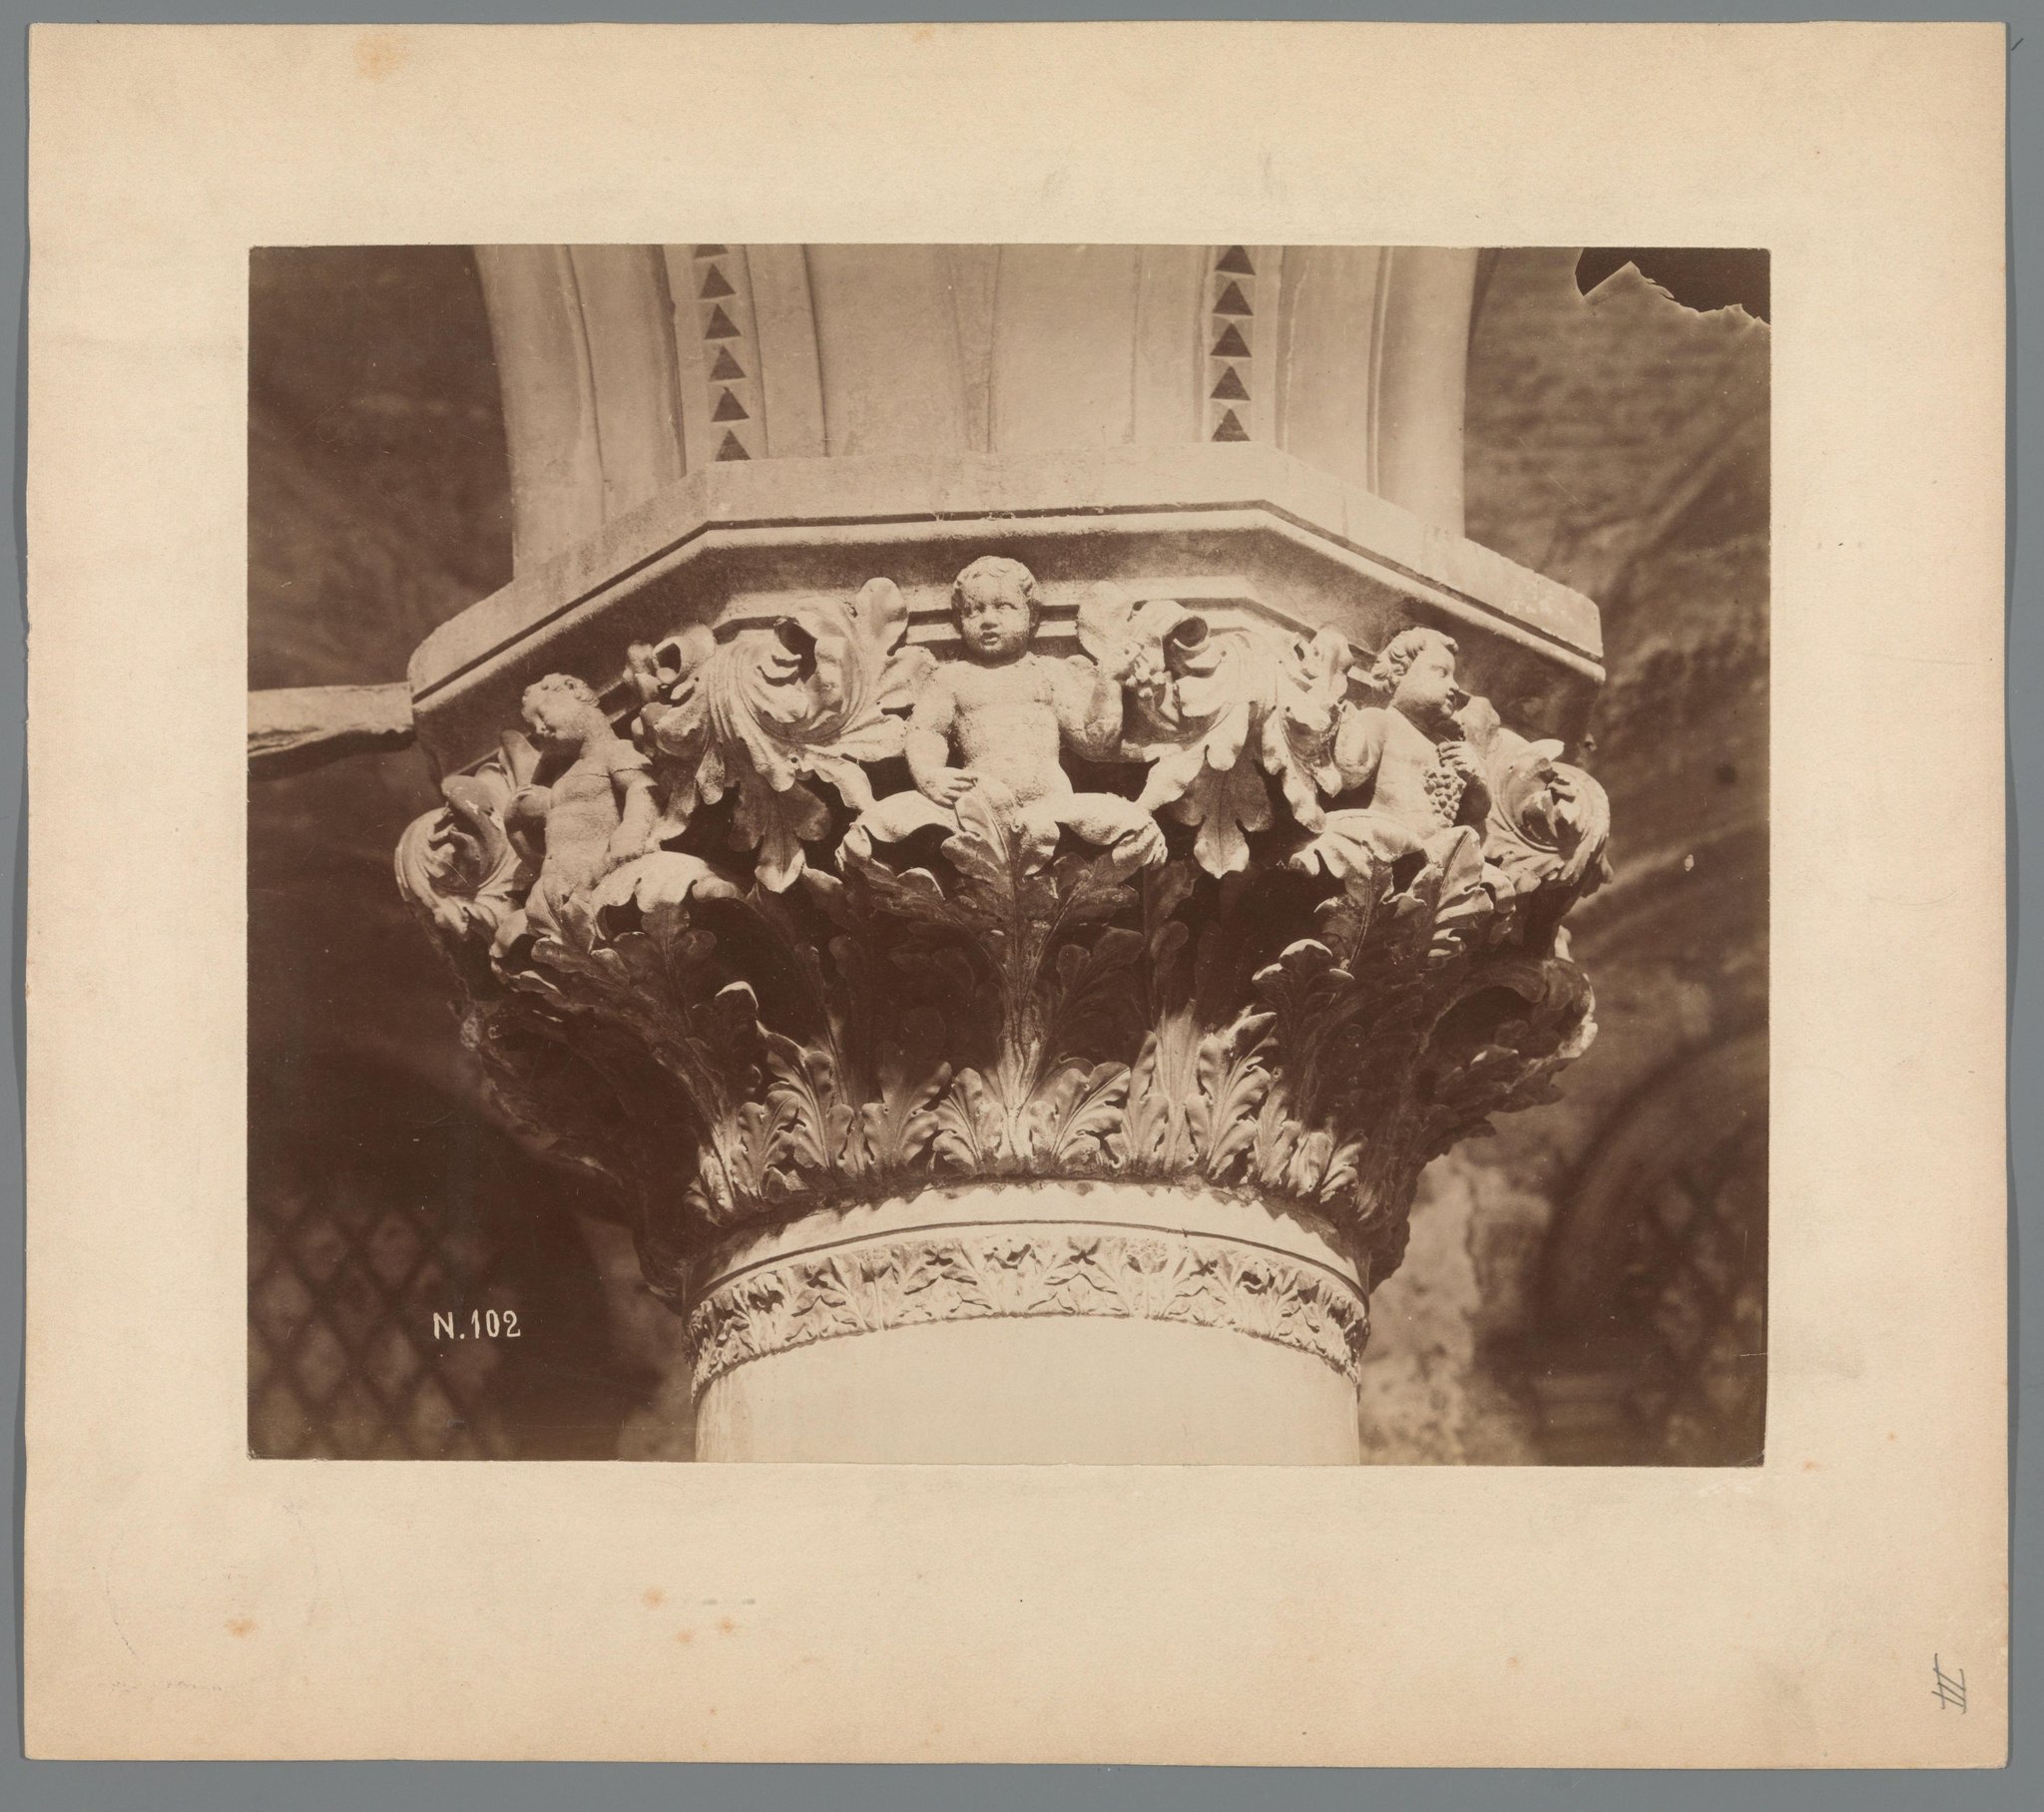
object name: photograph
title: Kapiteel gedecoreerd met putti en acanthusbladeren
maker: Anonymous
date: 1875-1900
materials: cardboard, photographic support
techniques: albumen print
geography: europe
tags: acanthus ~ ornament, capital (~ column, pillar), cupids: 'amores', 'amoretti', 'putti', europe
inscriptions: name: ‘J. A. G. DE LEUR Représentant Huigenspark, 40b. DEN HAAG’, collector's mark: Lugt 3937, number: ‘N. 102’